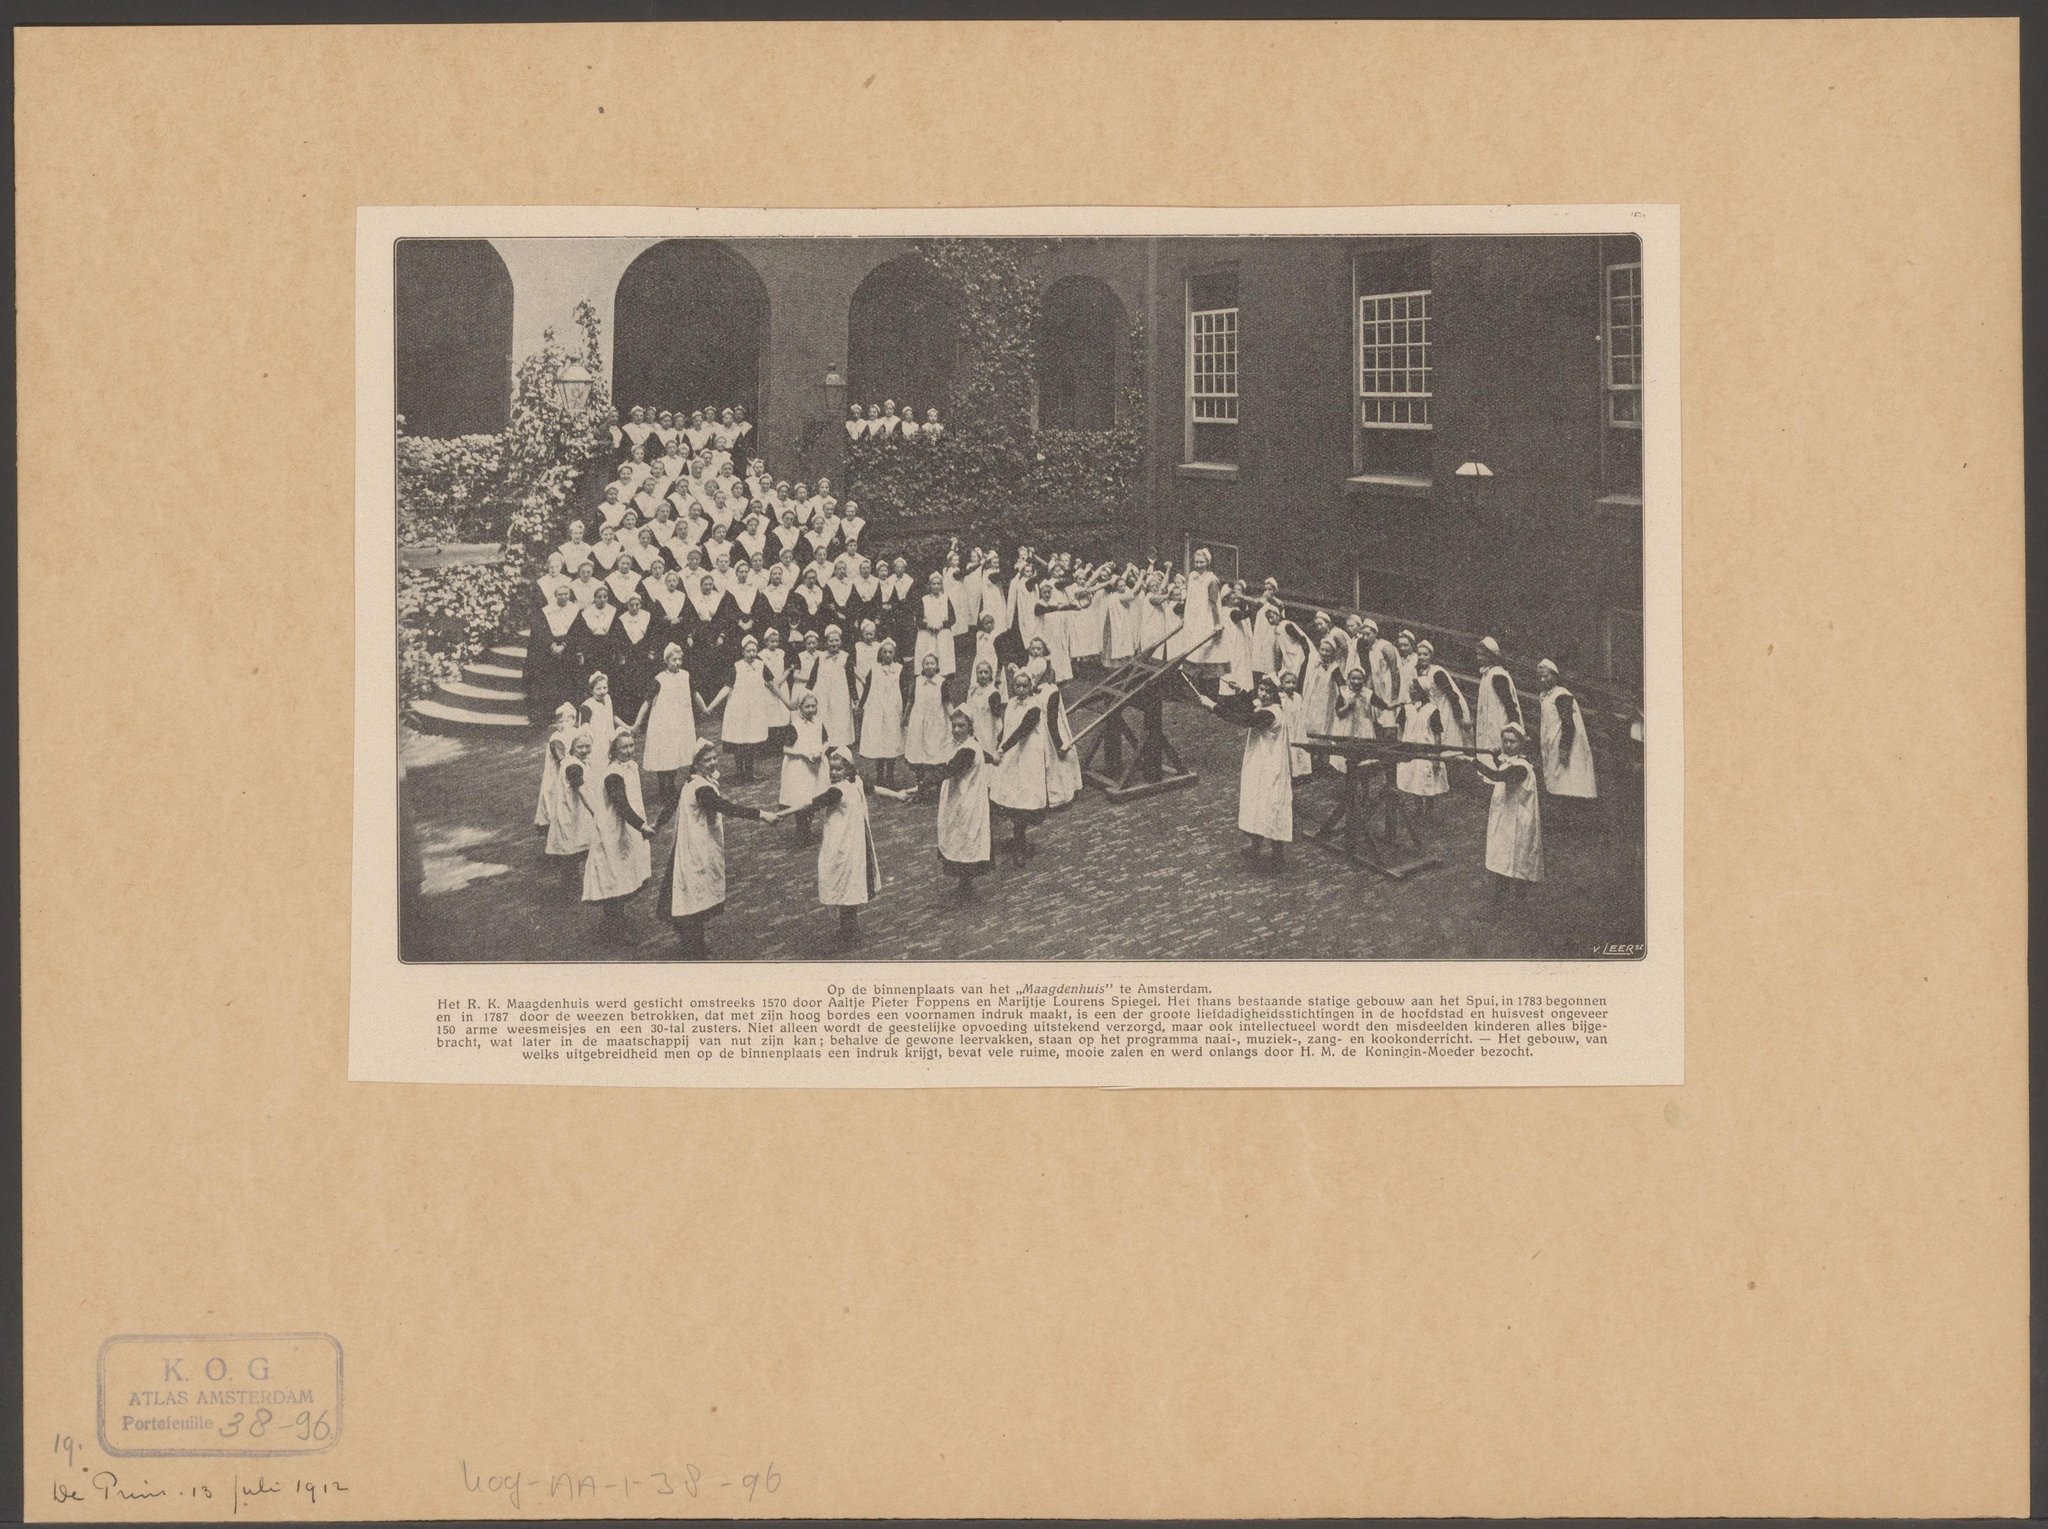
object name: photomechanical print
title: Wezen en nonnen op de binnenplaats van het Maagdenhuis te Amsterdam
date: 1912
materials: paper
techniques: letterpress printing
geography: amsterdam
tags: nun(s), courtyard, orphanage, orphans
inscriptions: collector's mark: Lugt 1641b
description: Onderwerpsrubriek binnen de Atlas Amsterdam: Armwezen en liefdadige instellingen: II. Kerkelijke inrichtingen: Rooms-Katholijk Maagden of Meisjesweeshuis.